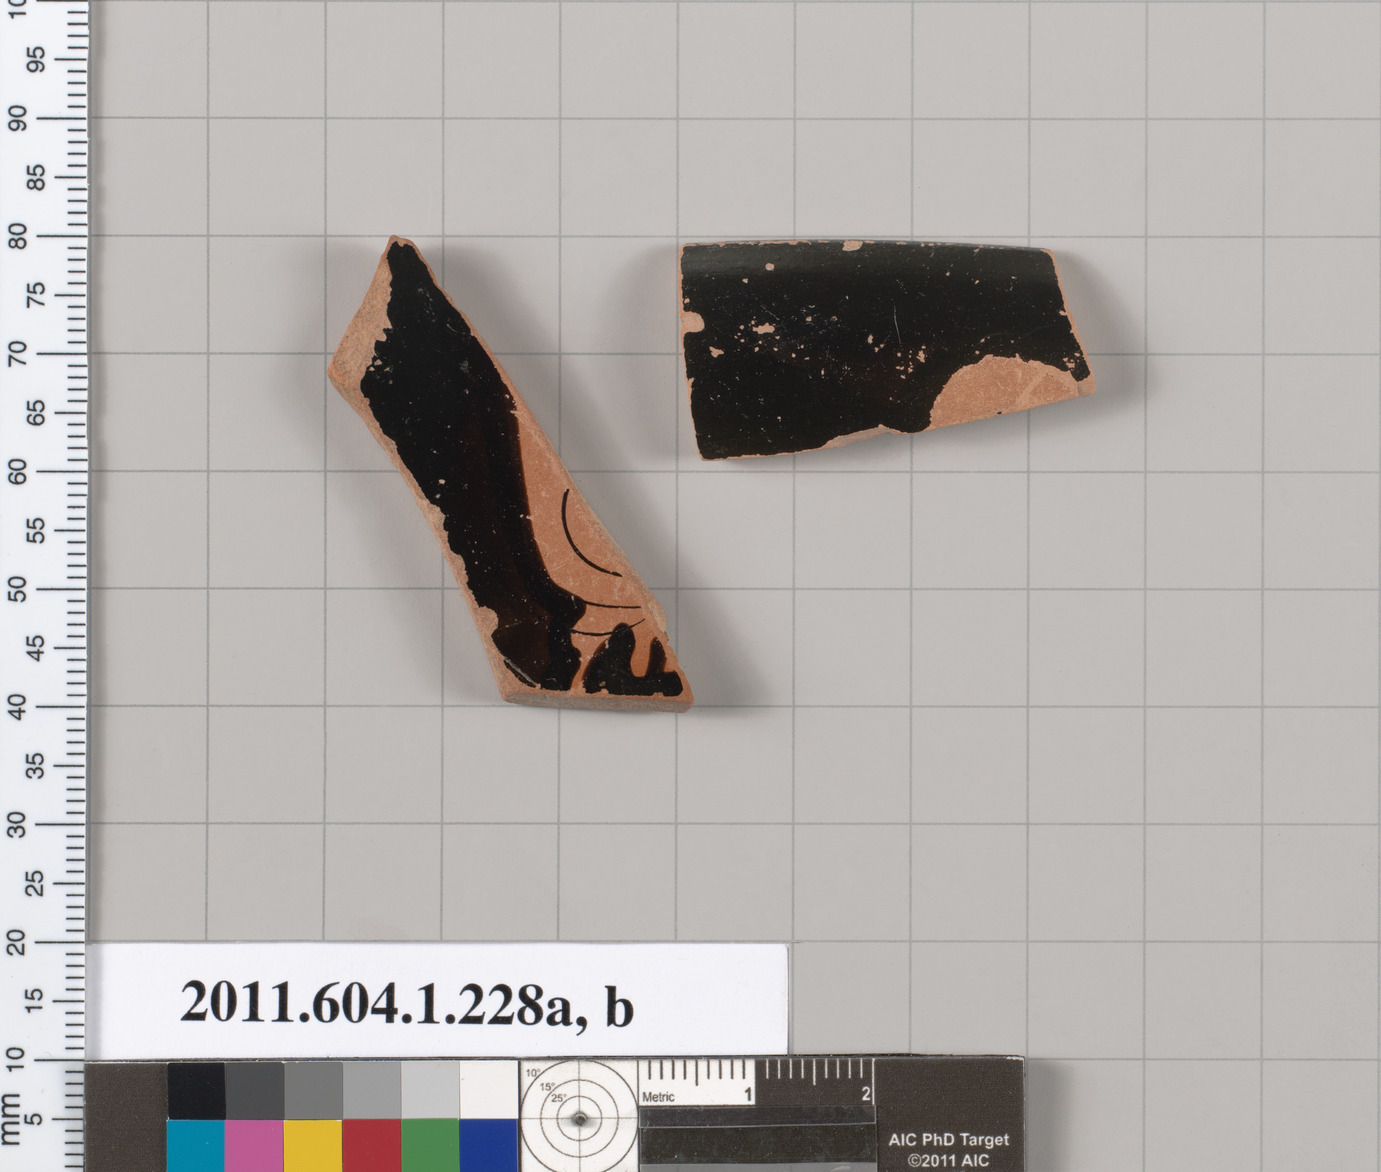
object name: kylix fragment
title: Terracotta fragments of a kylix (drinking cup)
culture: greek, attic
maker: painter of london d 12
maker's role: artist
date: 475-451 BCE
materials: terracotta